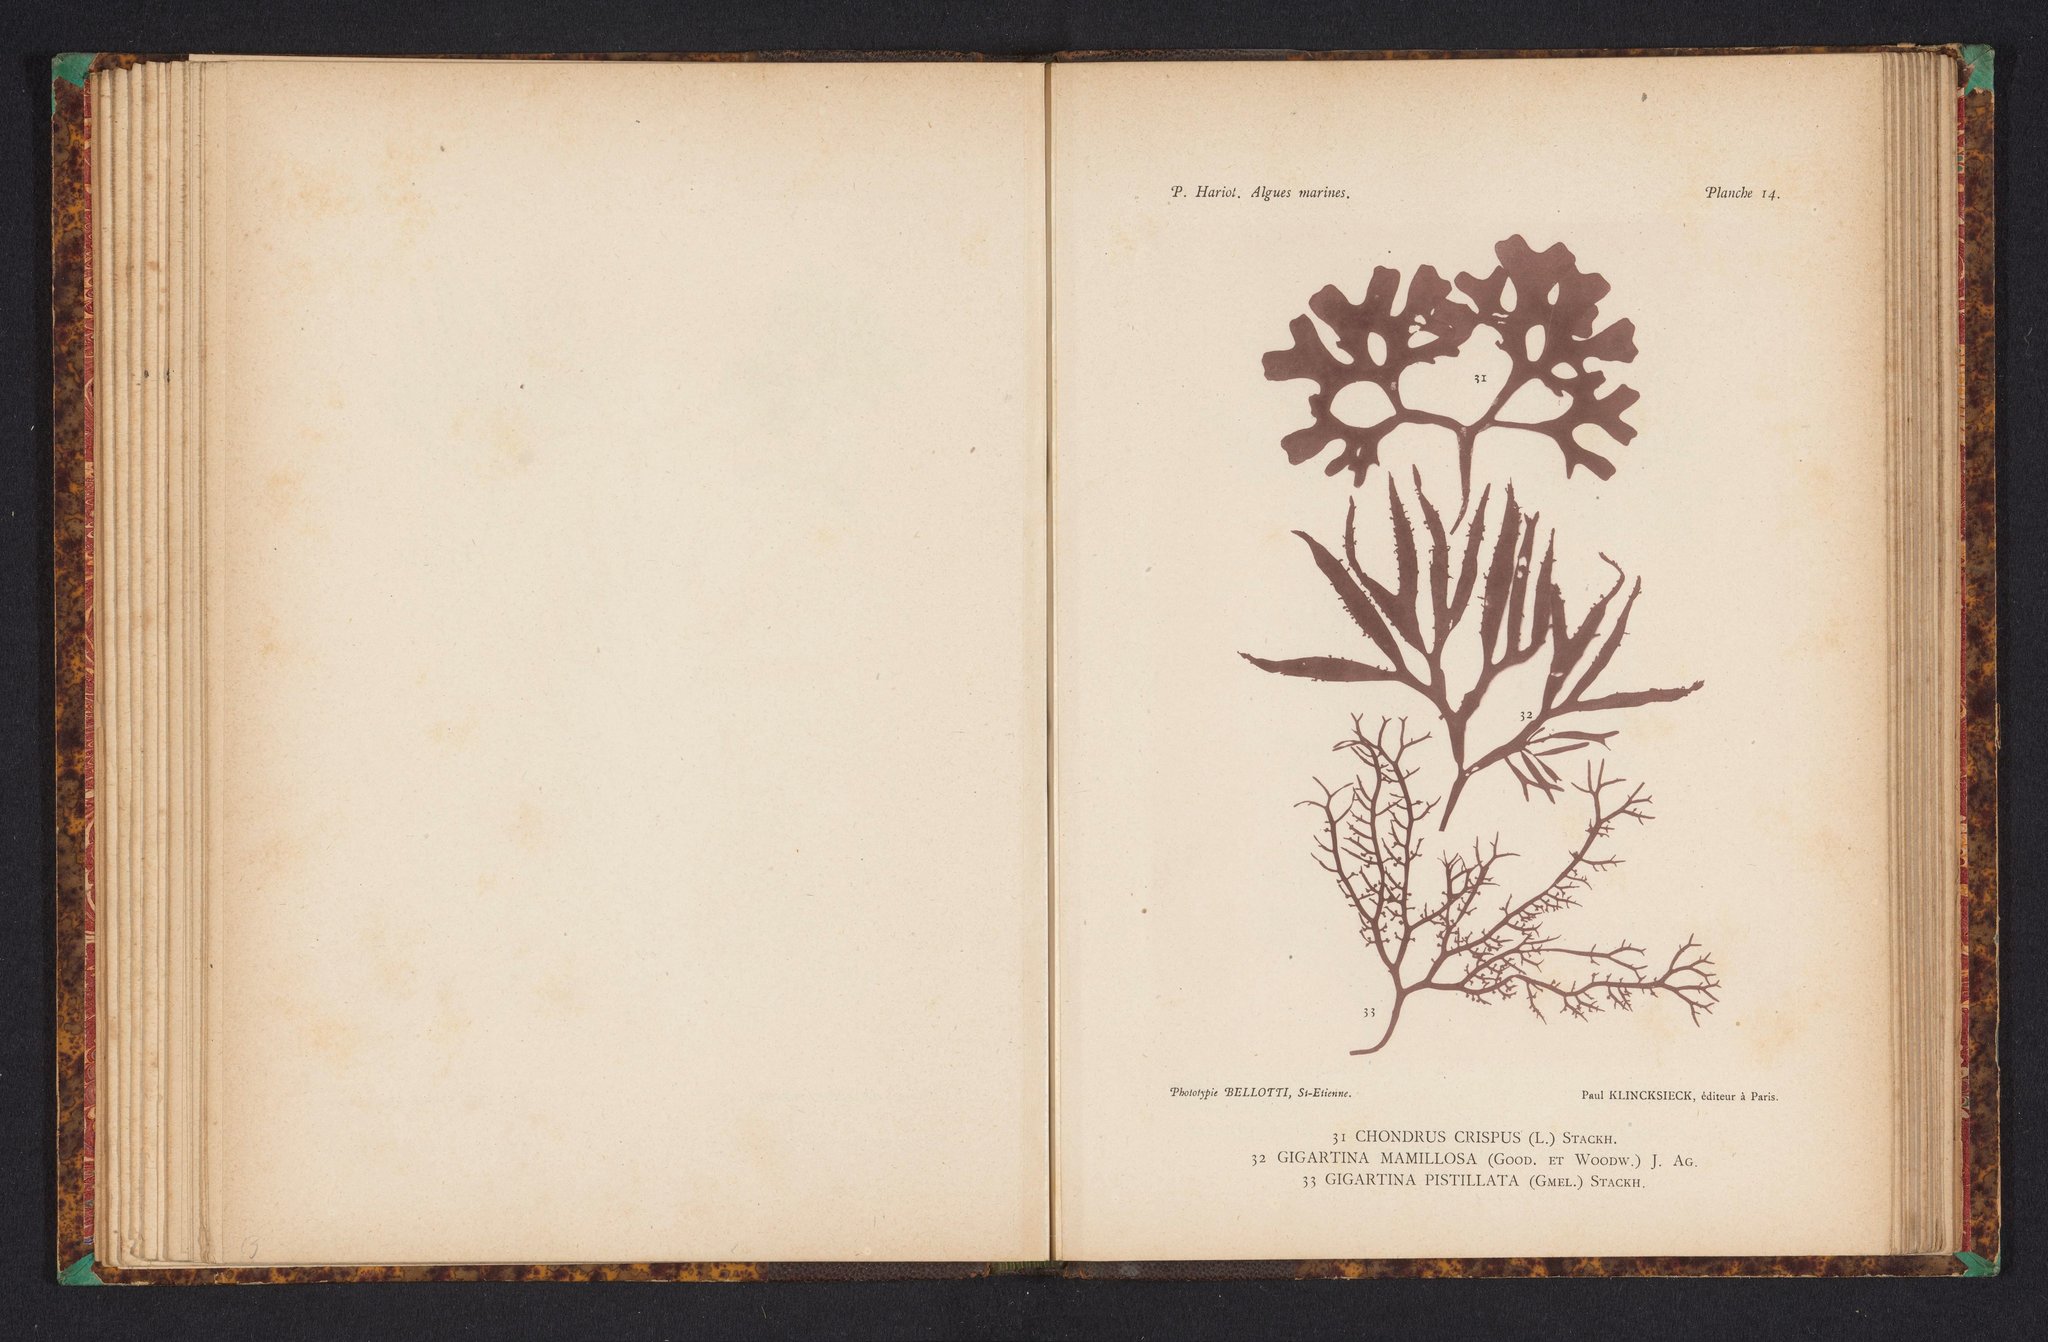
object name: page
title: Drie soorten zeewier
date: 1882-1892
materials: paper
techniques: photograph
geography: france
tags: algae, seaweed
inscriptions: inscription: ‘Chondrus (...) pistillata (Gmel.) Stackh.’, number: ‘31 (...) 33’, number: ‘Planche 14.’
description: (31) is Iers mos, (32) is Iers mos, (33) is roodwier.